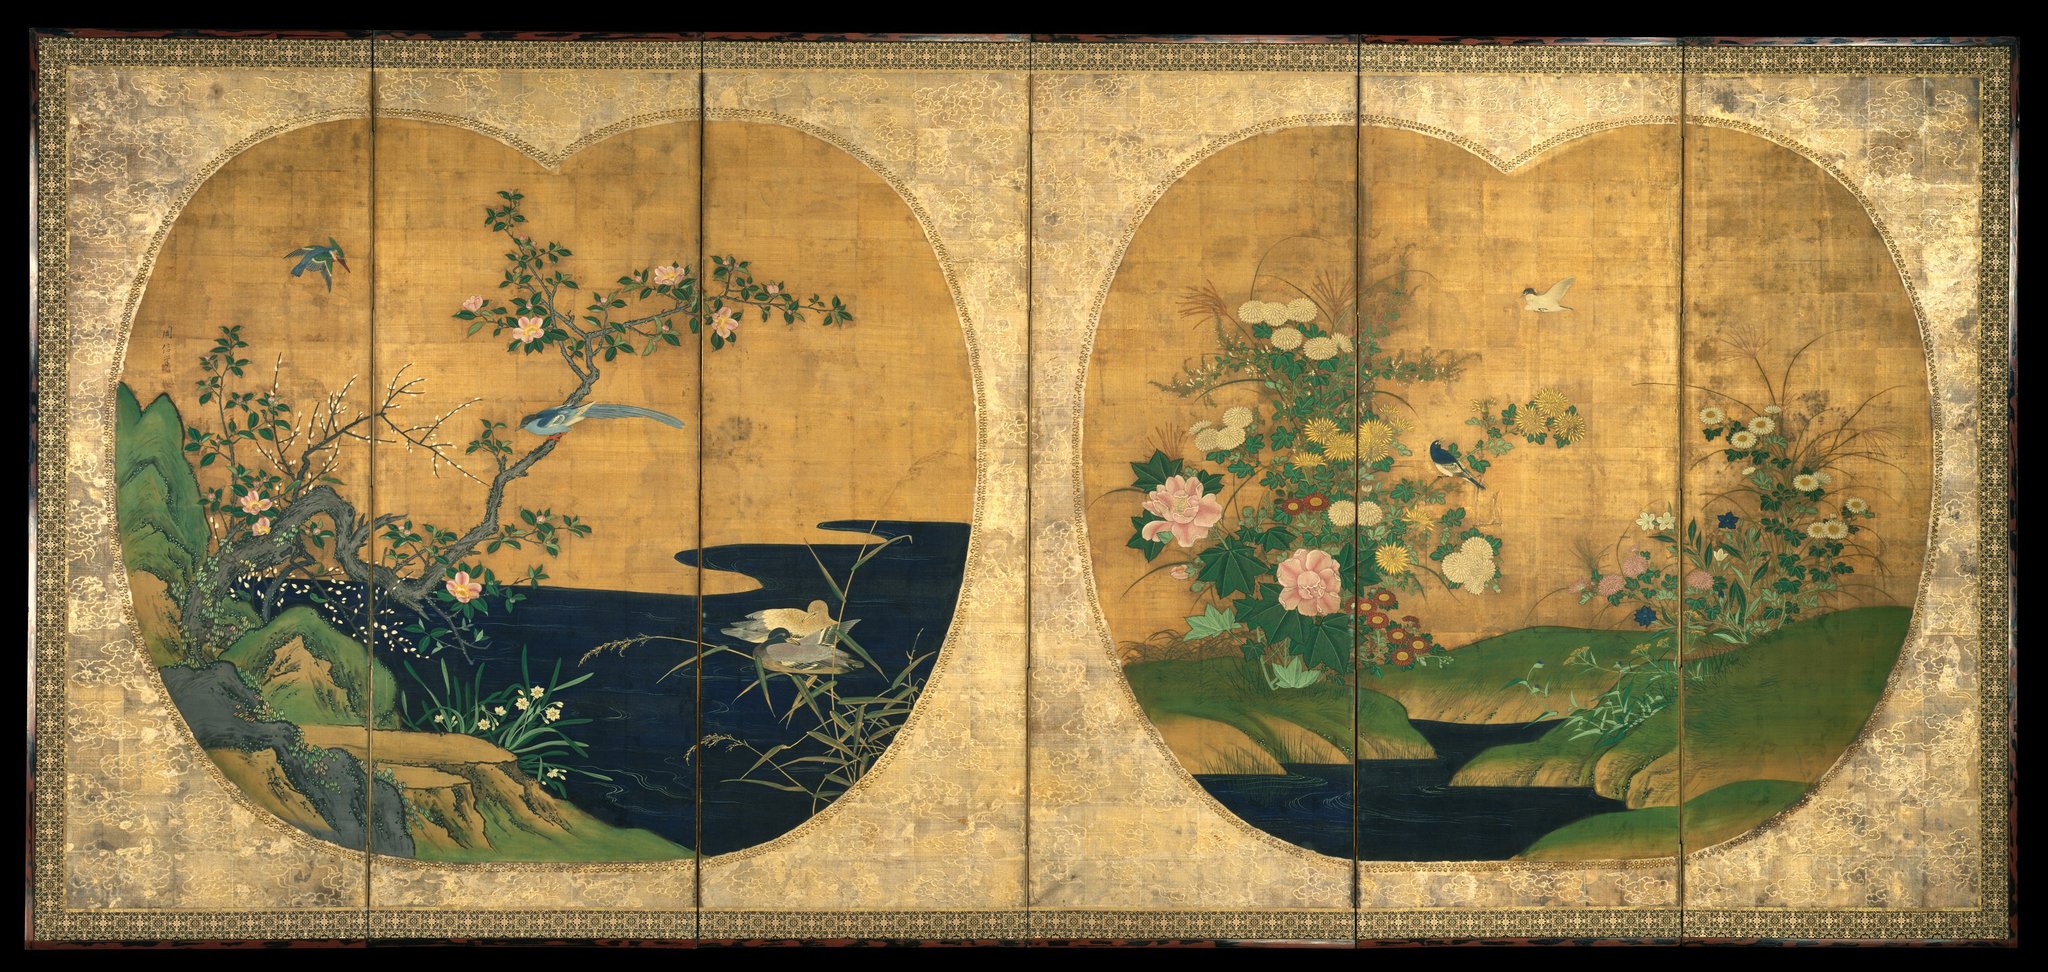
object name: screen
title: Birds and Flowers of Autumn and Winter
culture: japanese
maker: kano chikanobu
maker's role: artist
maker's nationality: japanese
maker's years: 1660-1728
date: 1701-1733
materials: ink, panel, silk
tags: birds,flowers,trees,autumn